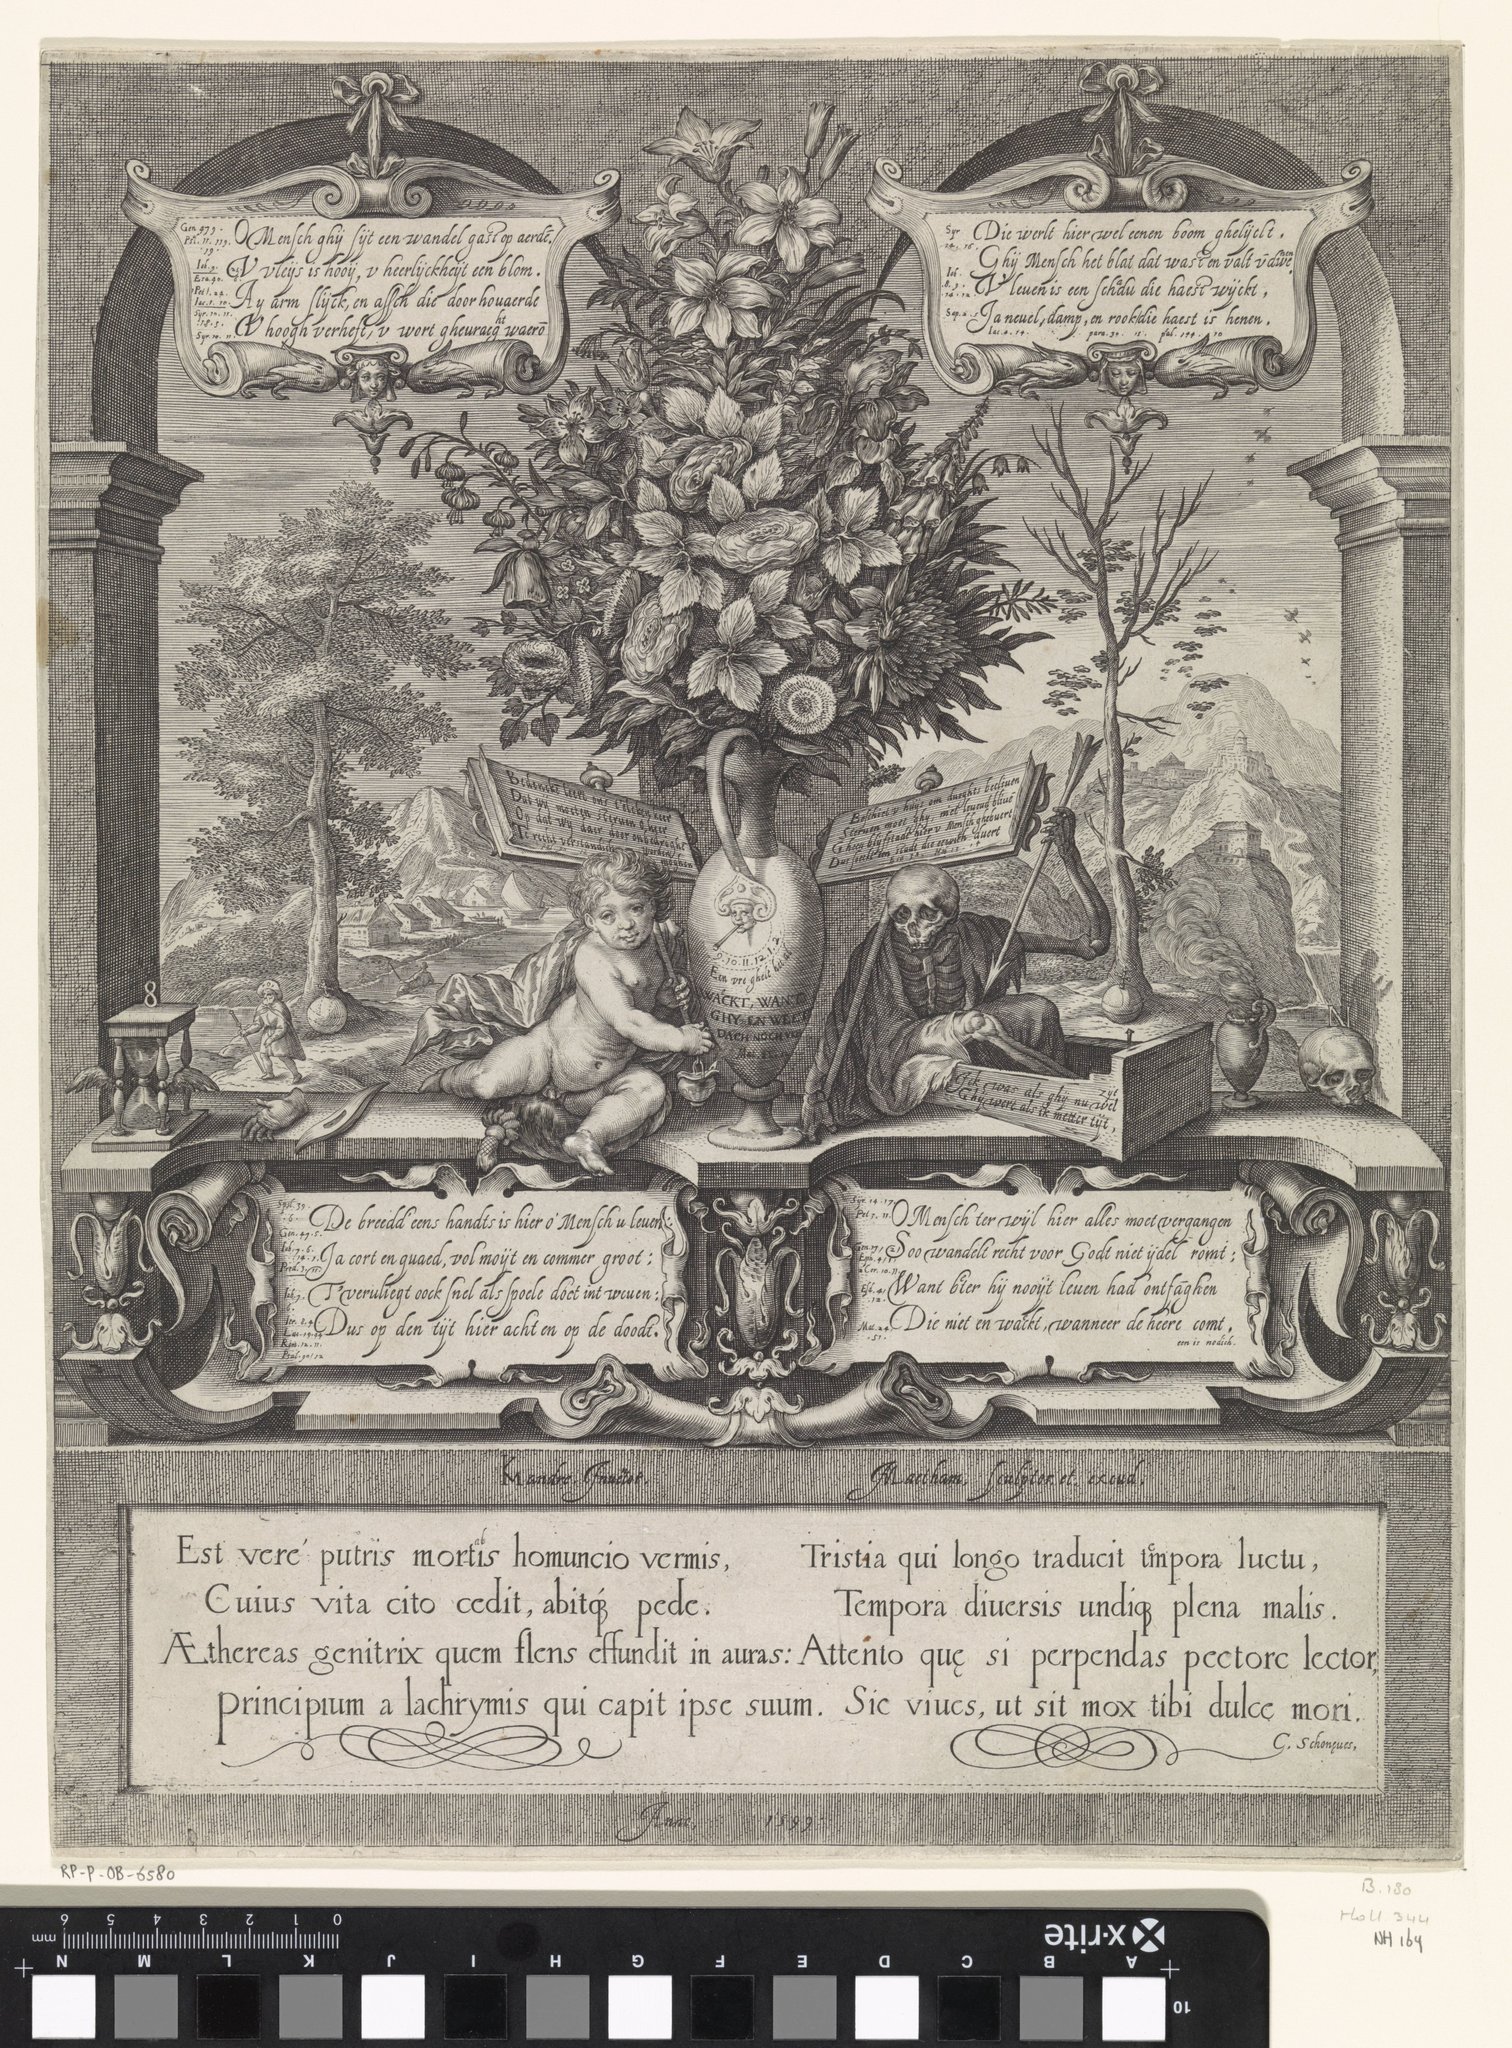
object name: print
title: Allegory of Transience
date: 1599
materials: paper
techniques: engraving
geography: haarlem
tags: 'vanitas' symbols, the life of man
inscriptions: collector's mark: Lugt 2228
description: Every element in this charged depiction recalls the inevitability of death, including the huge bouquet. The inscription on the vase admonishes us to ‘Stay vigilant, for you know neither the day nor the hour’. The flowers, and by extension, humans blossom, wither, and ultimately die. These gorgeous paper floral treasures, however, have withstood the ravages of time for more than four centuries.